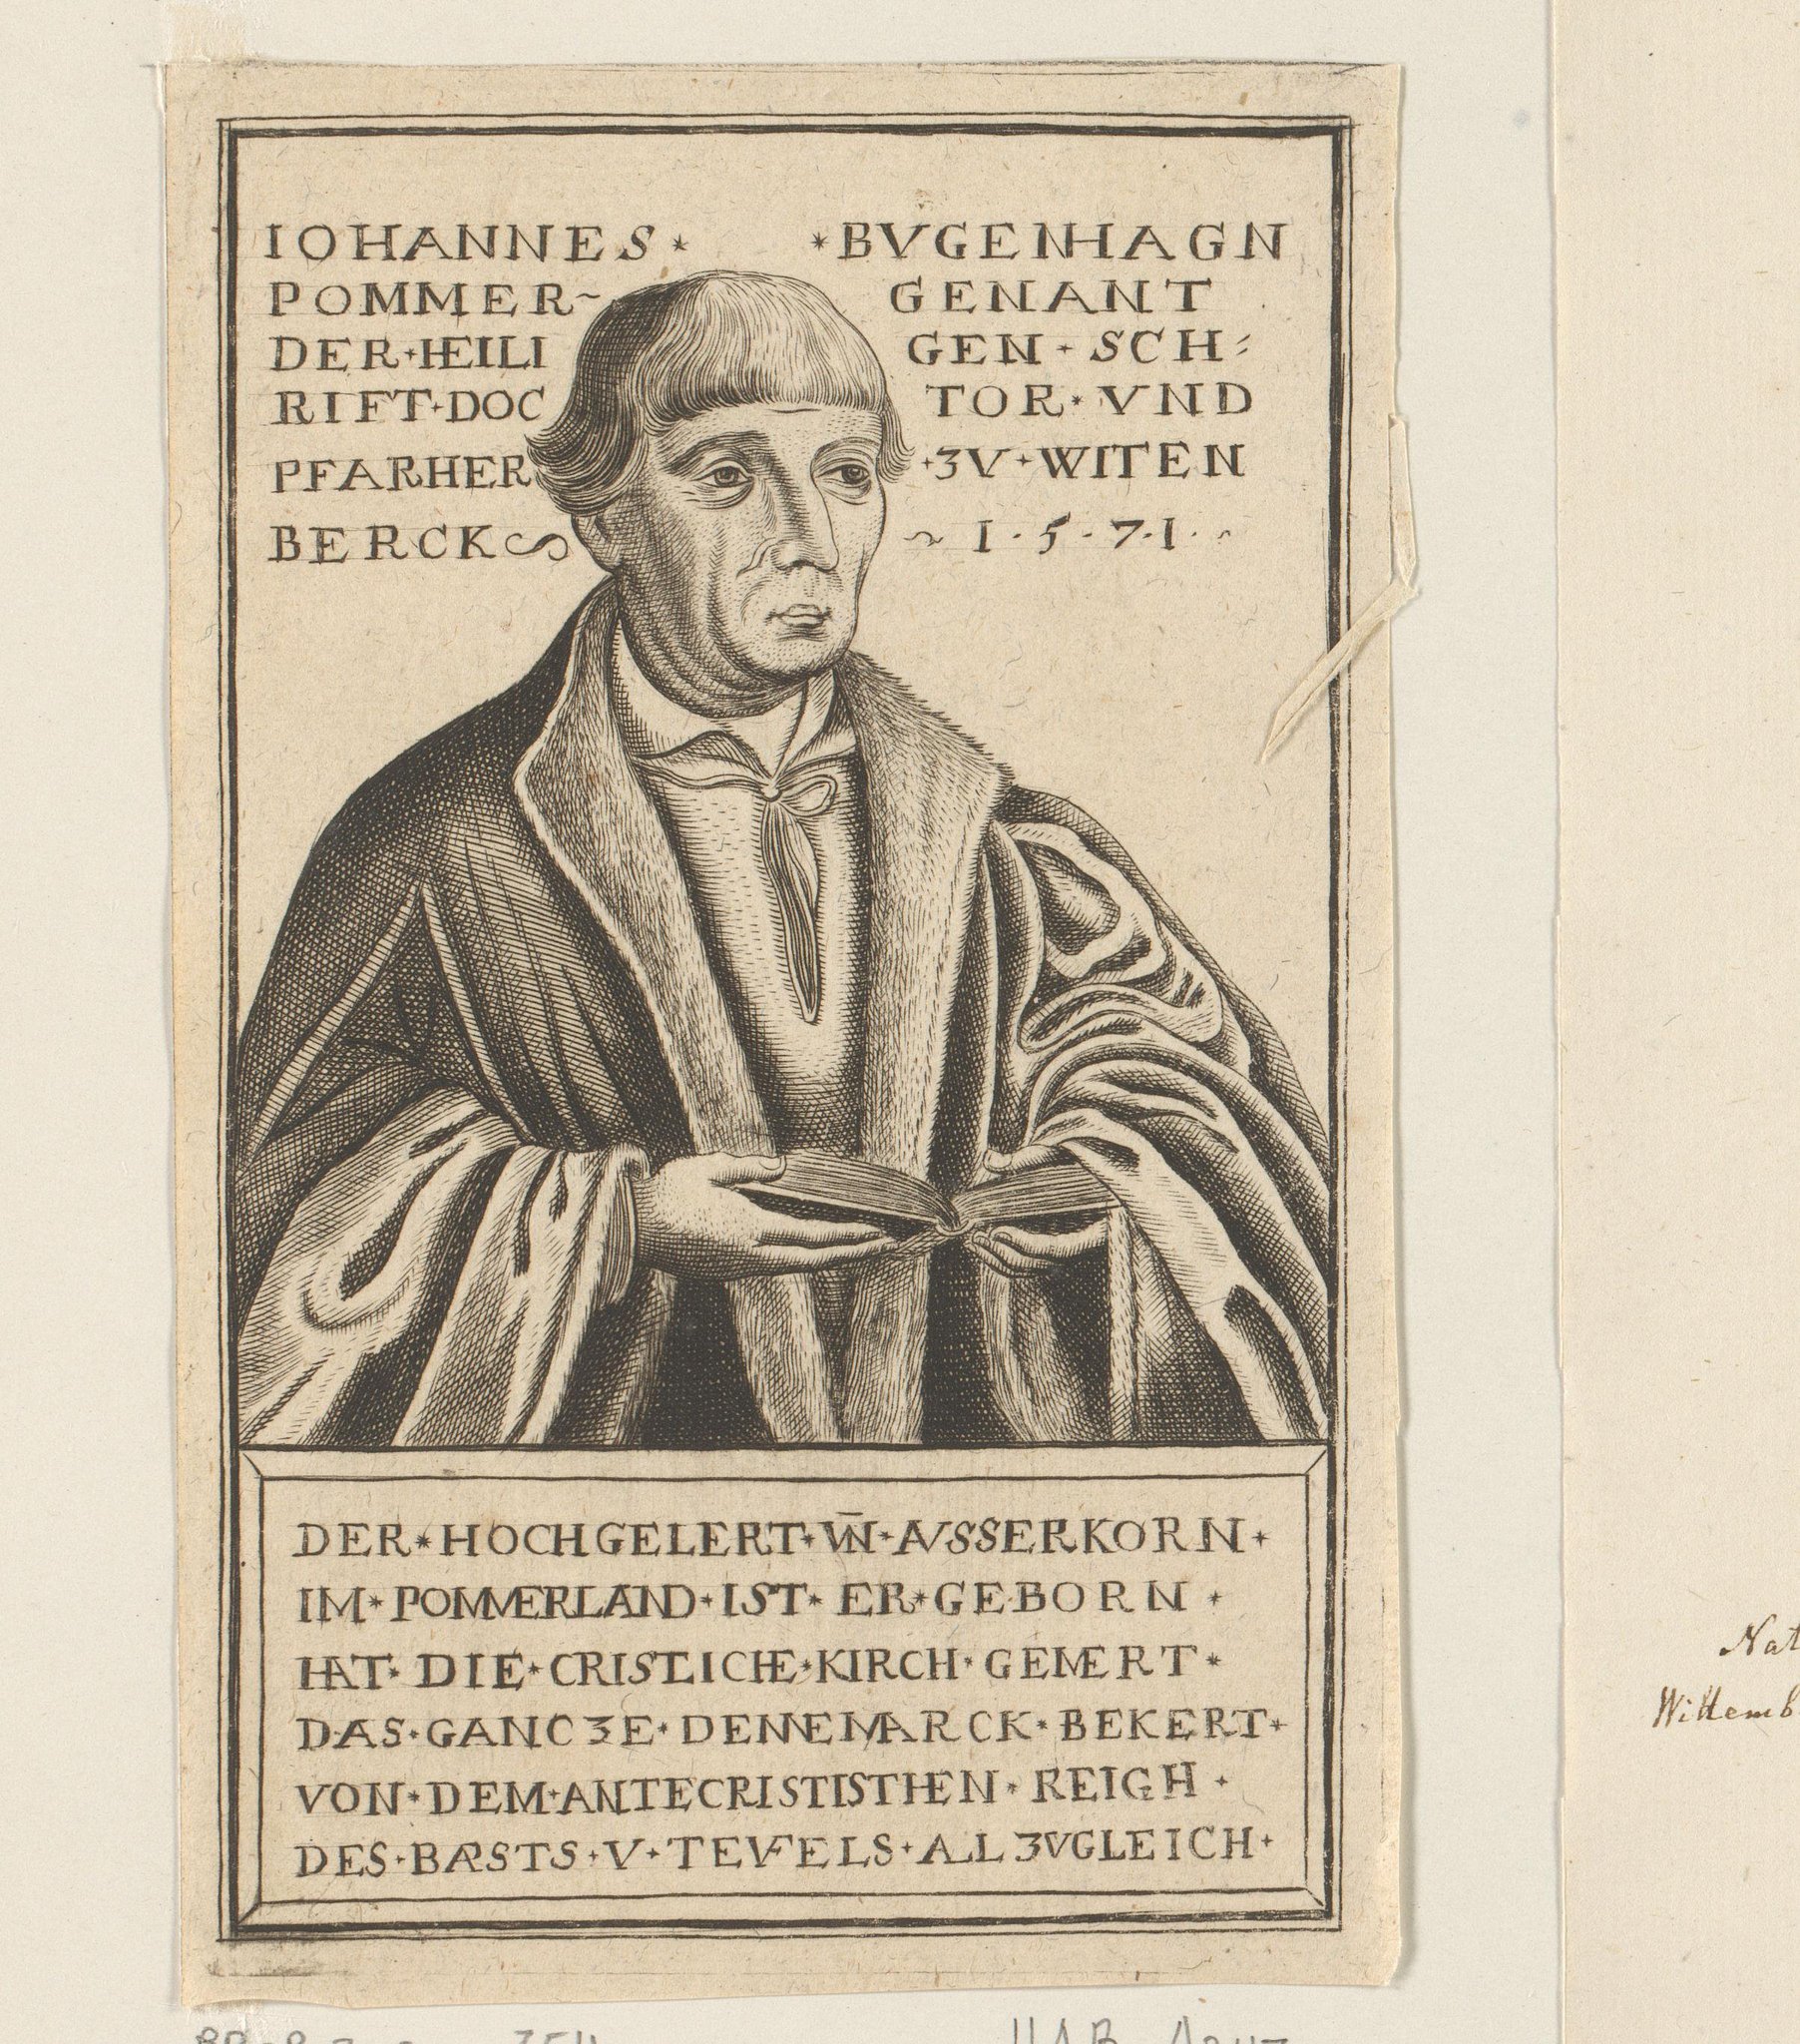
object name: book illustration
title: Johannes Bugenhagn Pommer genant (...)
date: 1718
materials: paper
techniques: engraving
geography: leipzig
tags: theologian, historical persons, book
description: Prent uit: Unschuldige Nachrichten von Alten und Neuen Theologischen Sachen (...). Leipzig: Johann Friedrich Braun, 1718, dl. 2.